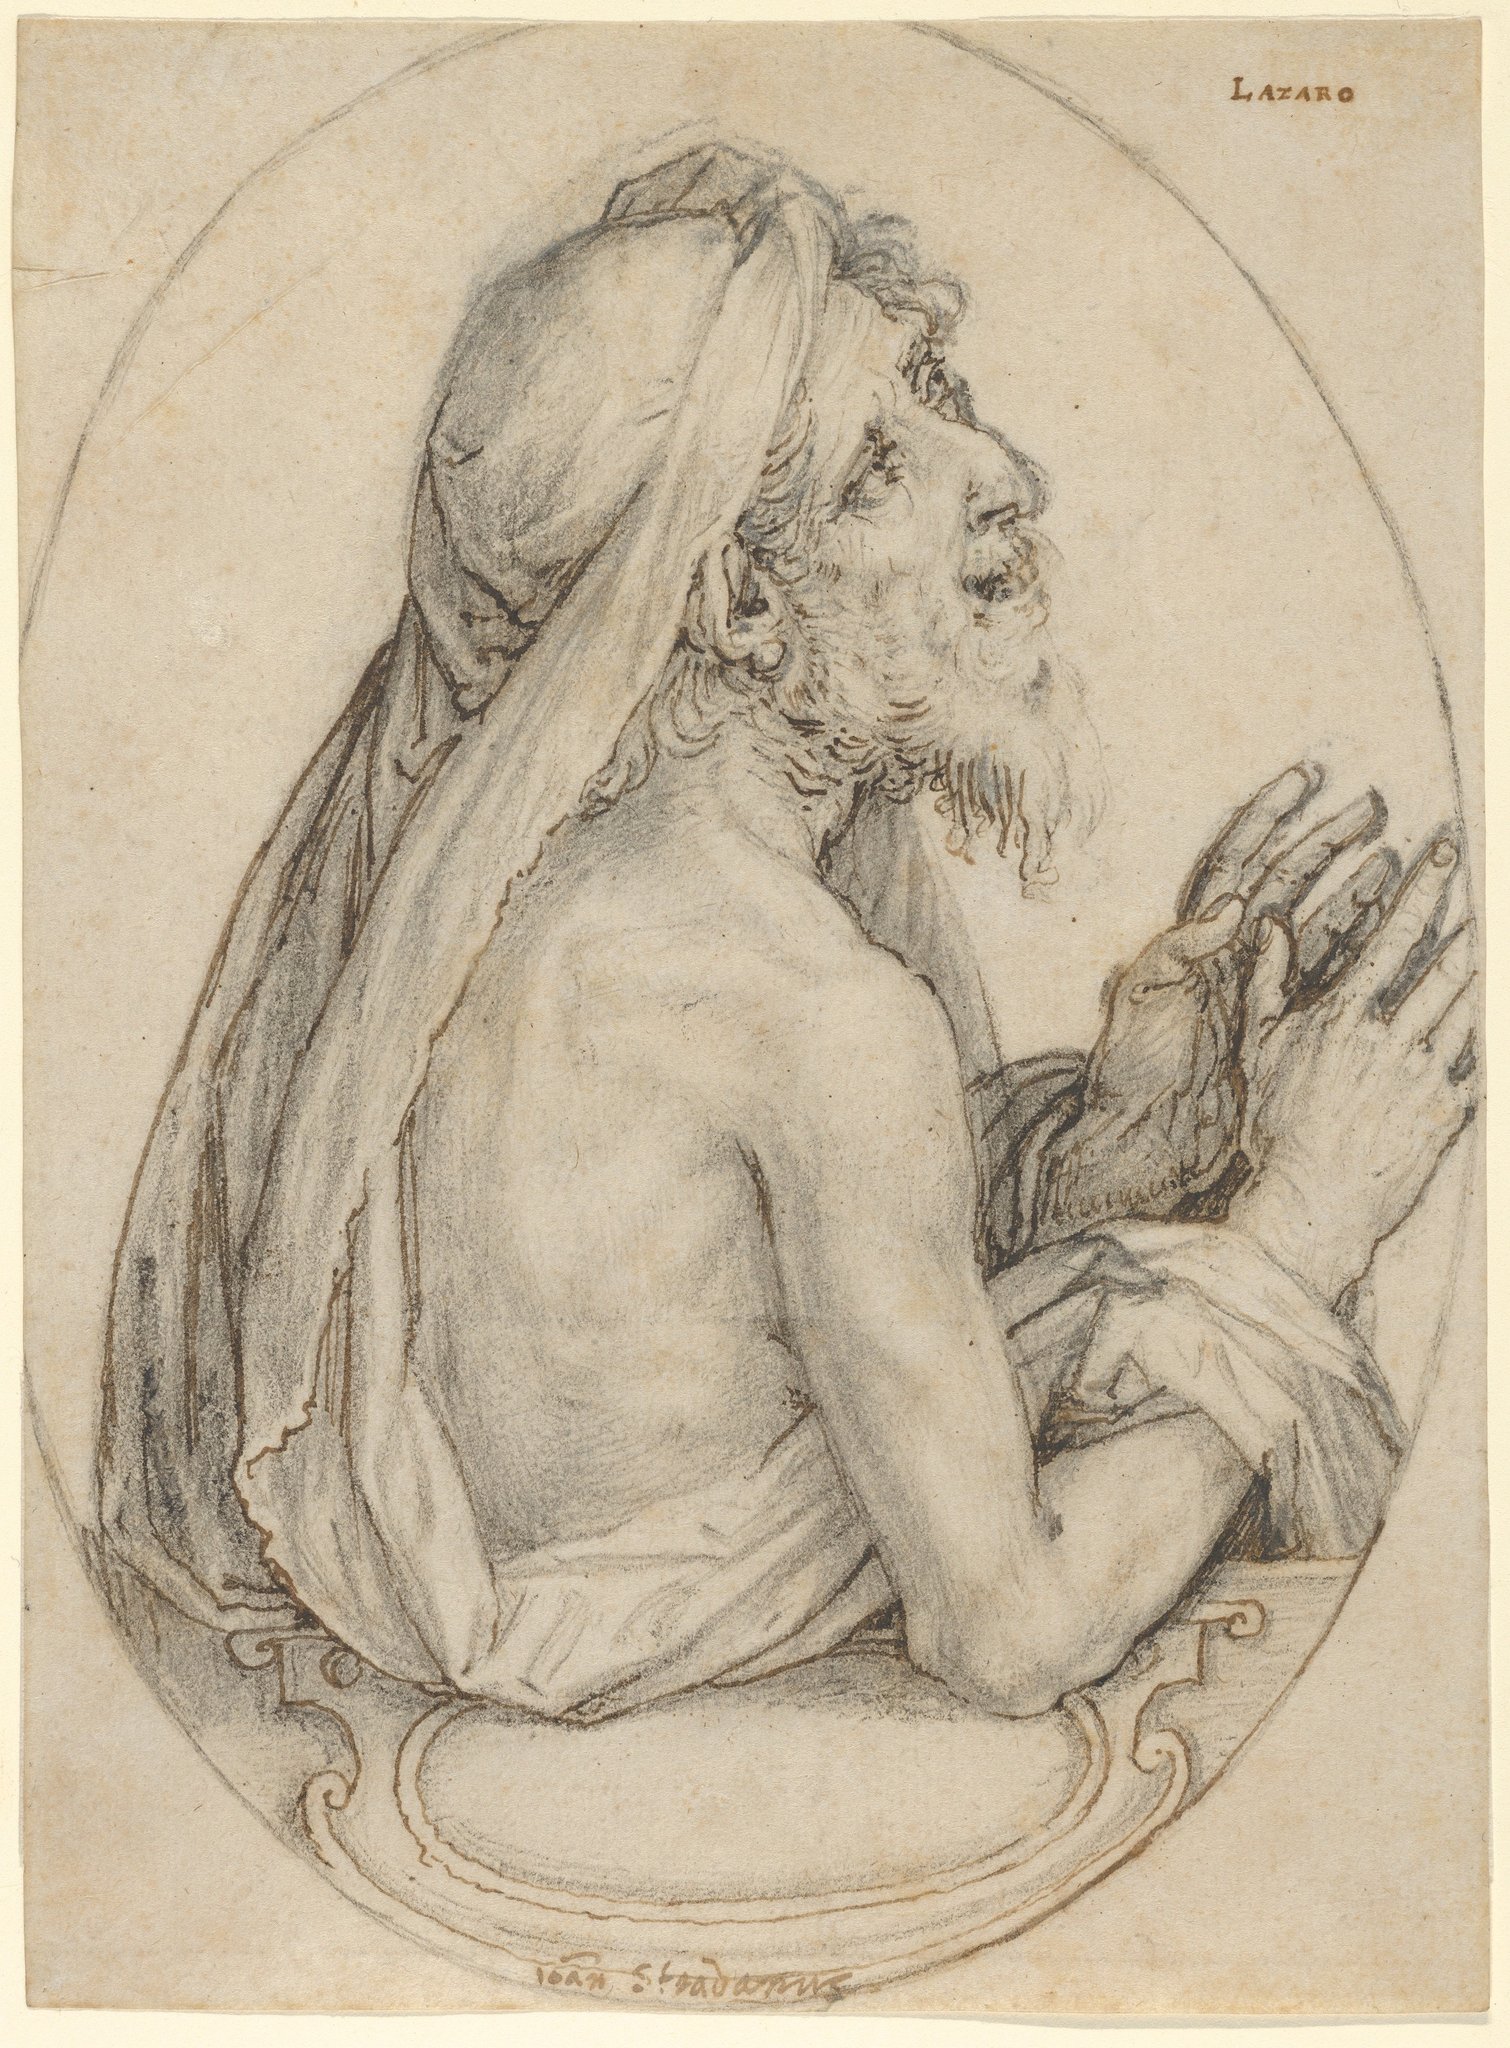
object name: drawing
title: Lazarus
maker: jan van der straet, called stradanus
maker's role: artist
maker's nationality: netherlandish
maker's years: 1523-1605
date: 1605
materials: chalk, graphite, ink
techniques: pen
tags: saints